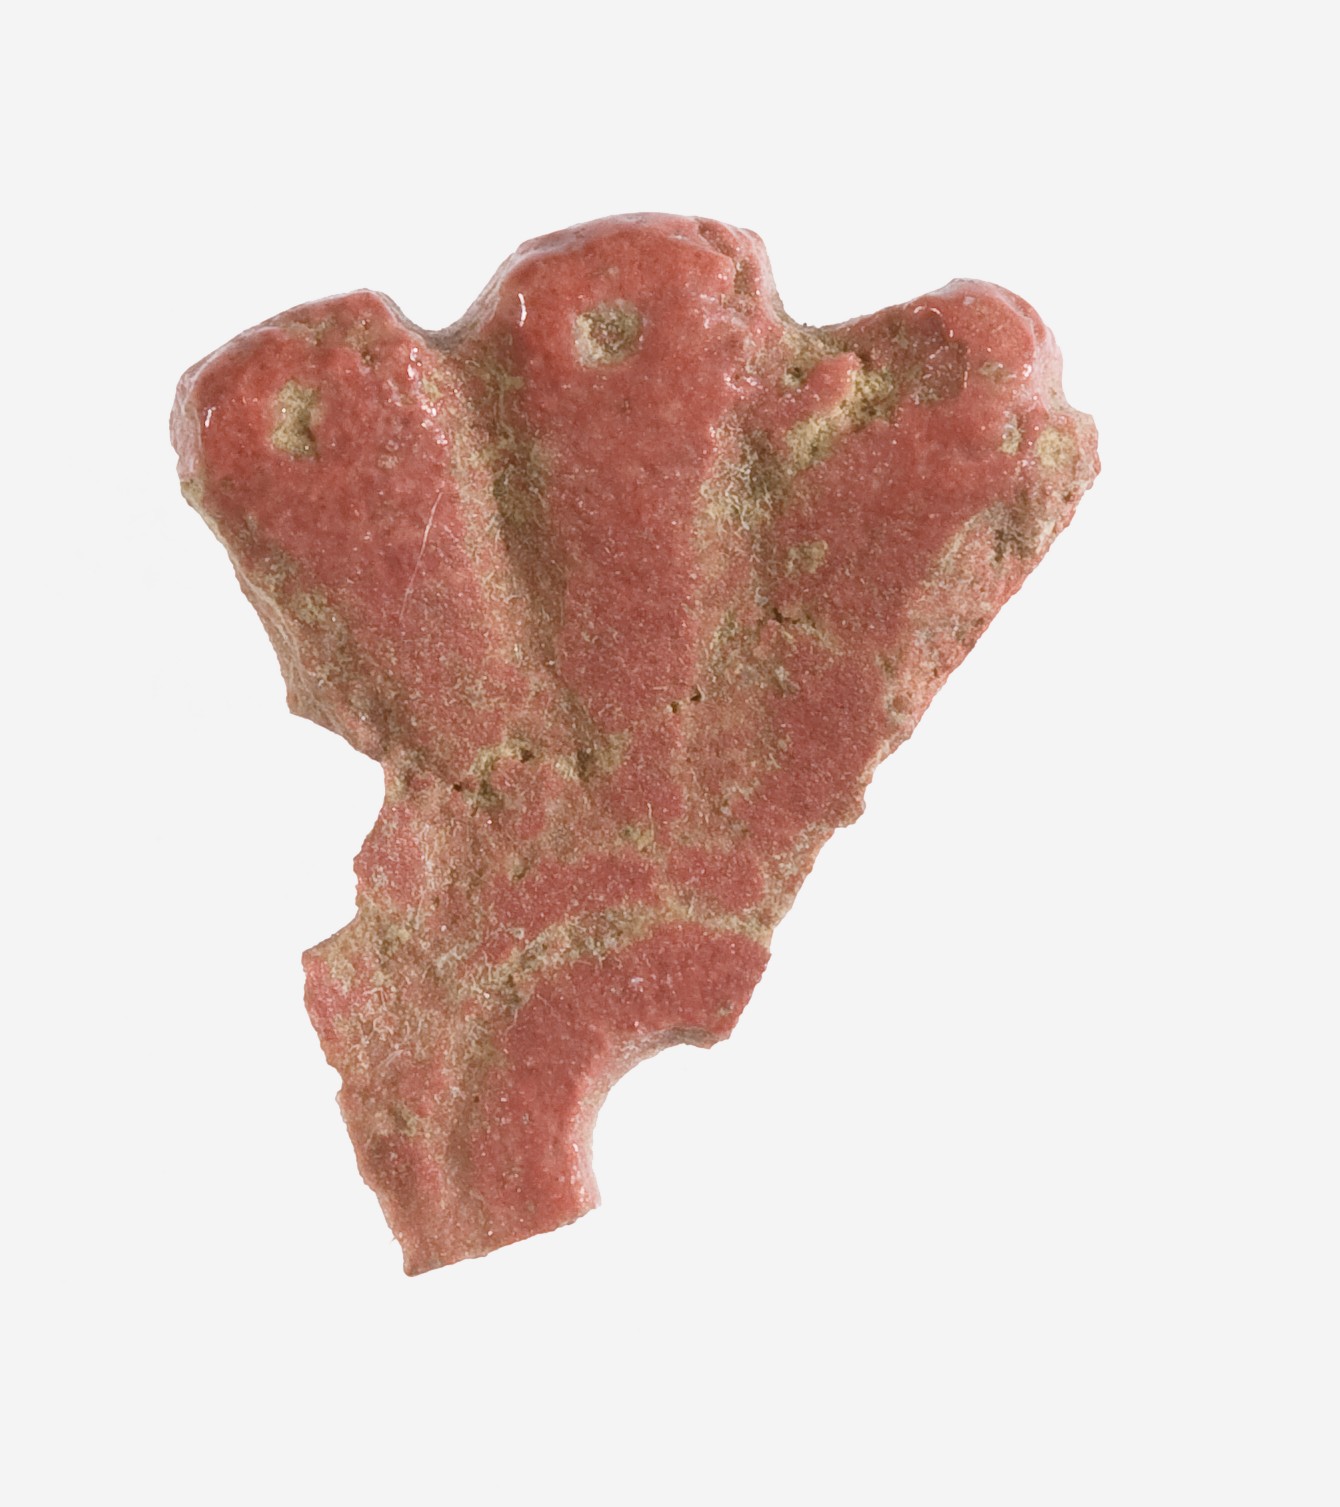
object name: pendant, daisy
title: Daisy Pendant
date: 1390-1352 BCE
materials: faience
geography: egypt